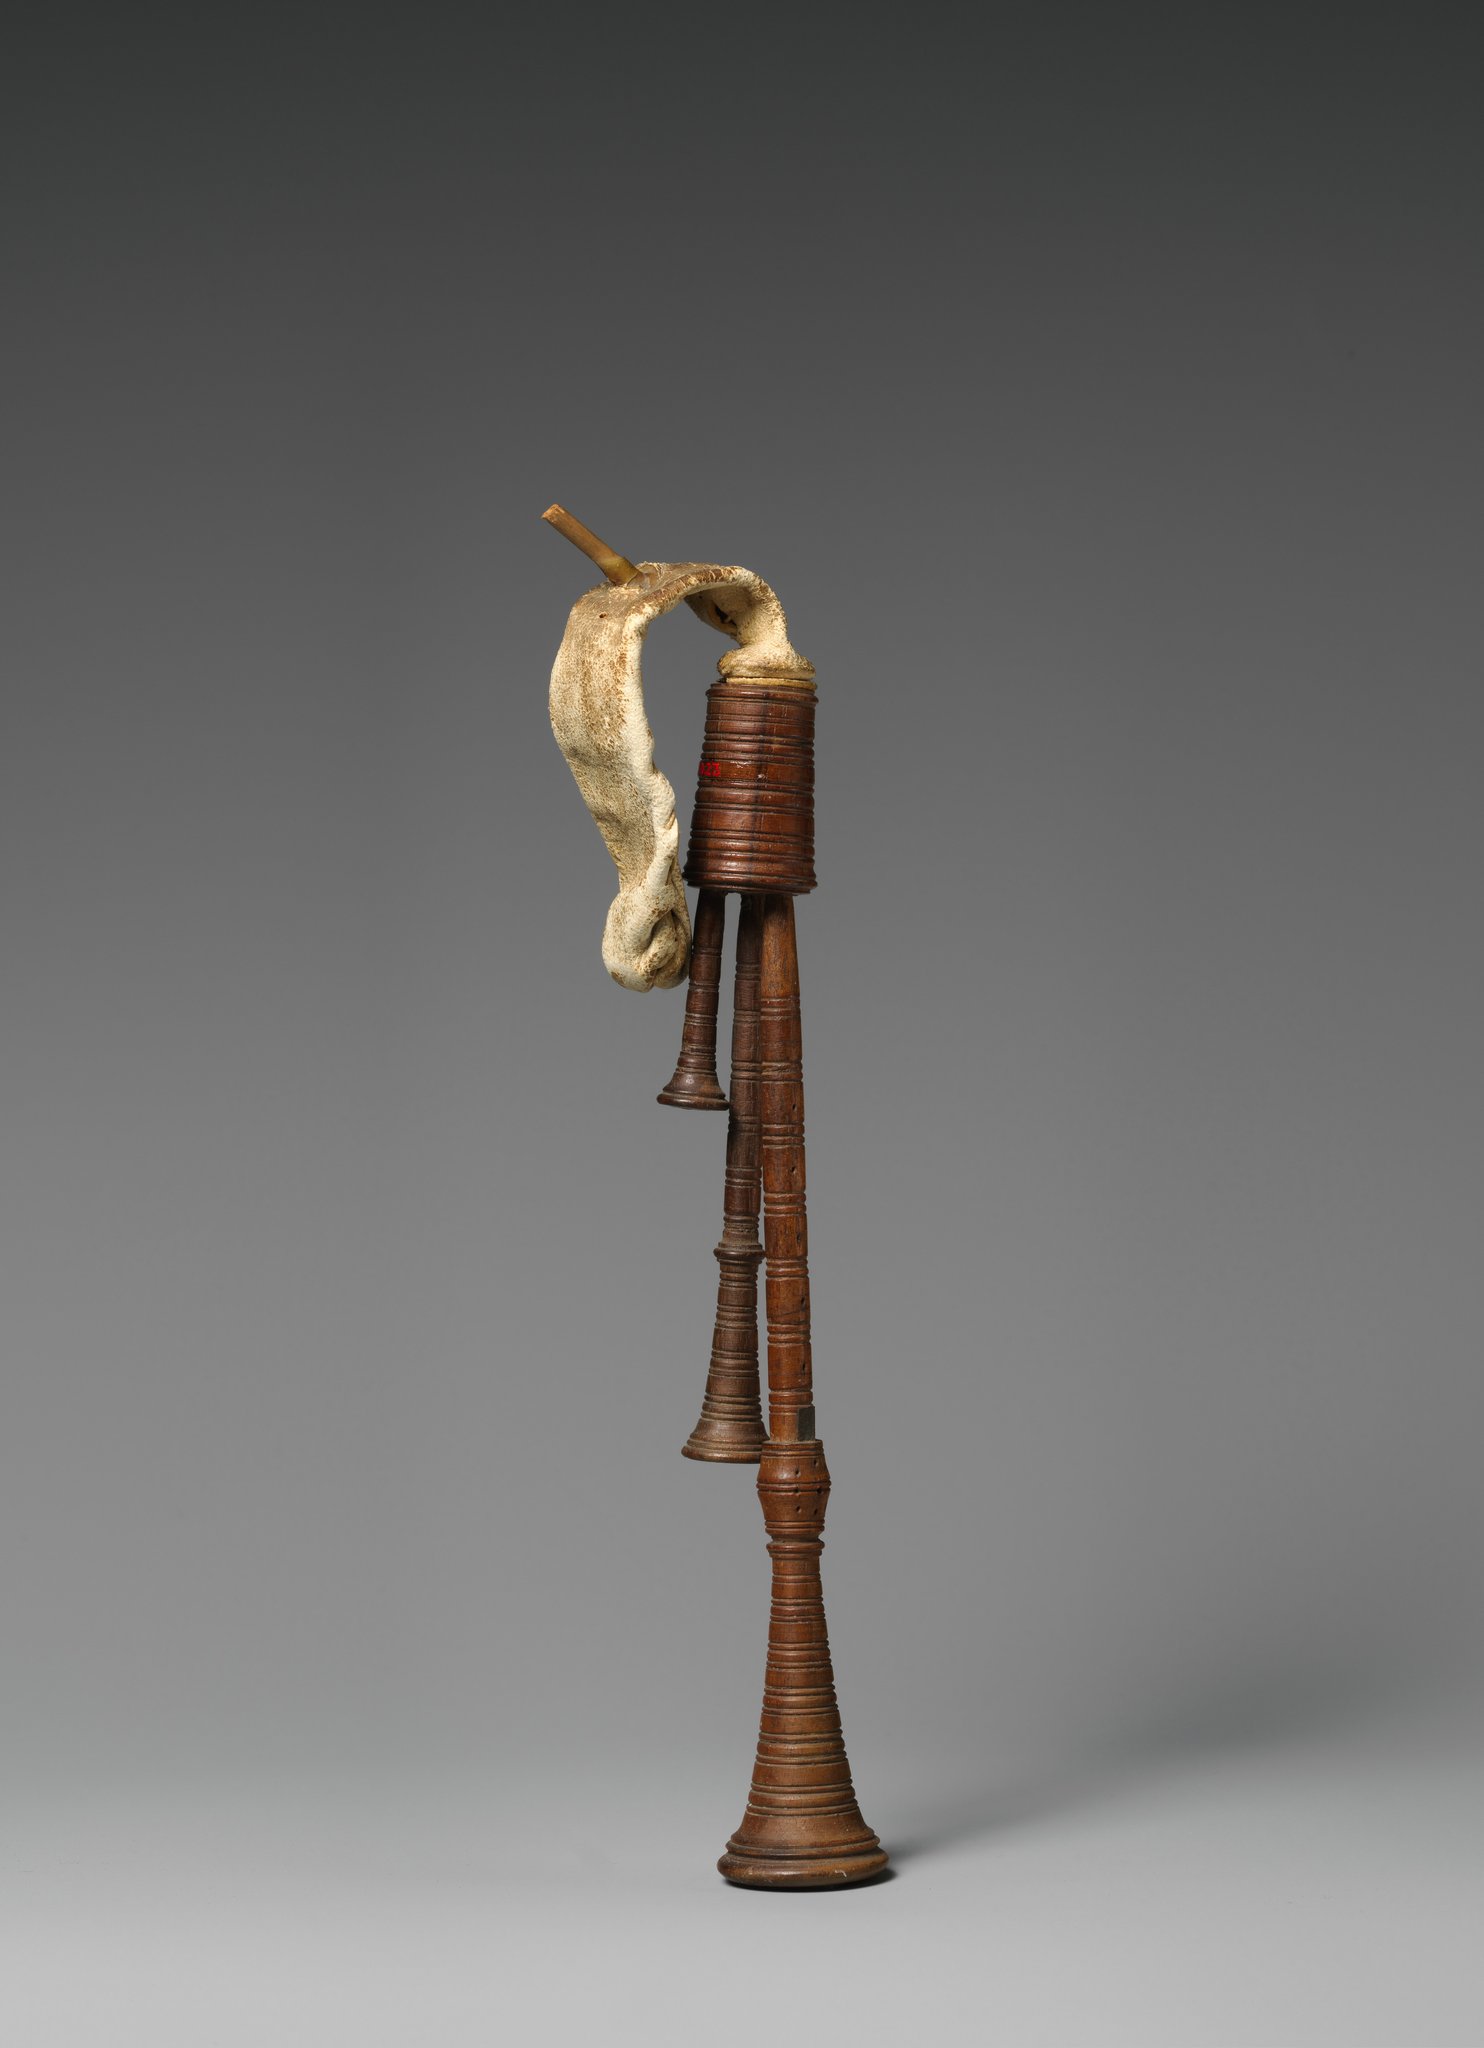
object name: crèche accessory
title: Bagpipe (crèche accessory)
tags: bagpipes